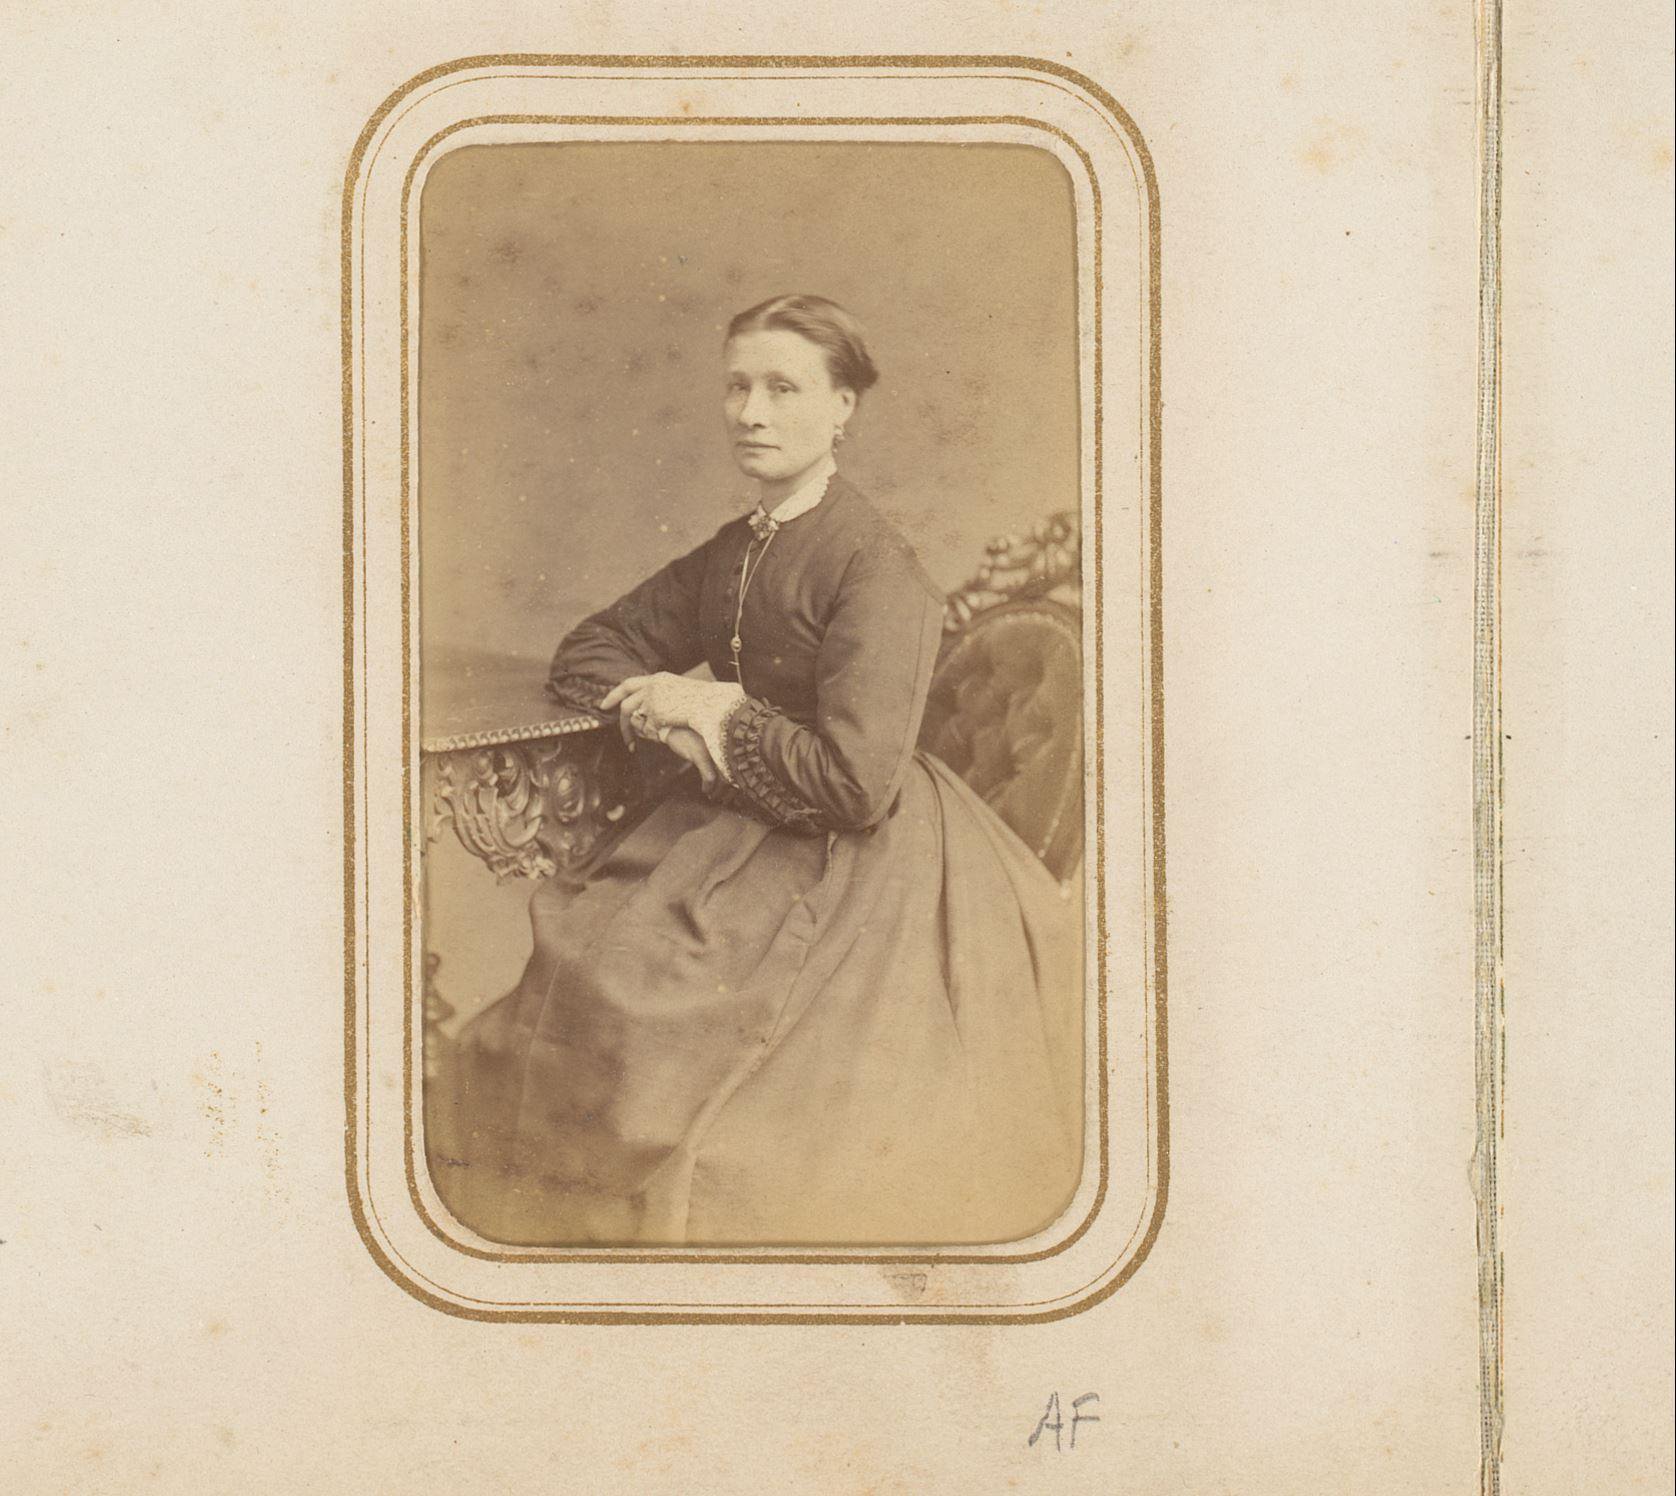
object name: carte de visite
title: Portret van een zittende vrouw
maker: albert greiner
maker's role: fotograaf, fotostudio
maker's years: 1833-1890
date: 1861-1874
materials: cardboard, photographic support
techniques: albumen print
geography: amsterdam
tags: historical persons - bb - woman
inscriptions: inscription: ‘A. Greiner/ Photograf/ Nieuwendijk L.87/ Amsterdam’